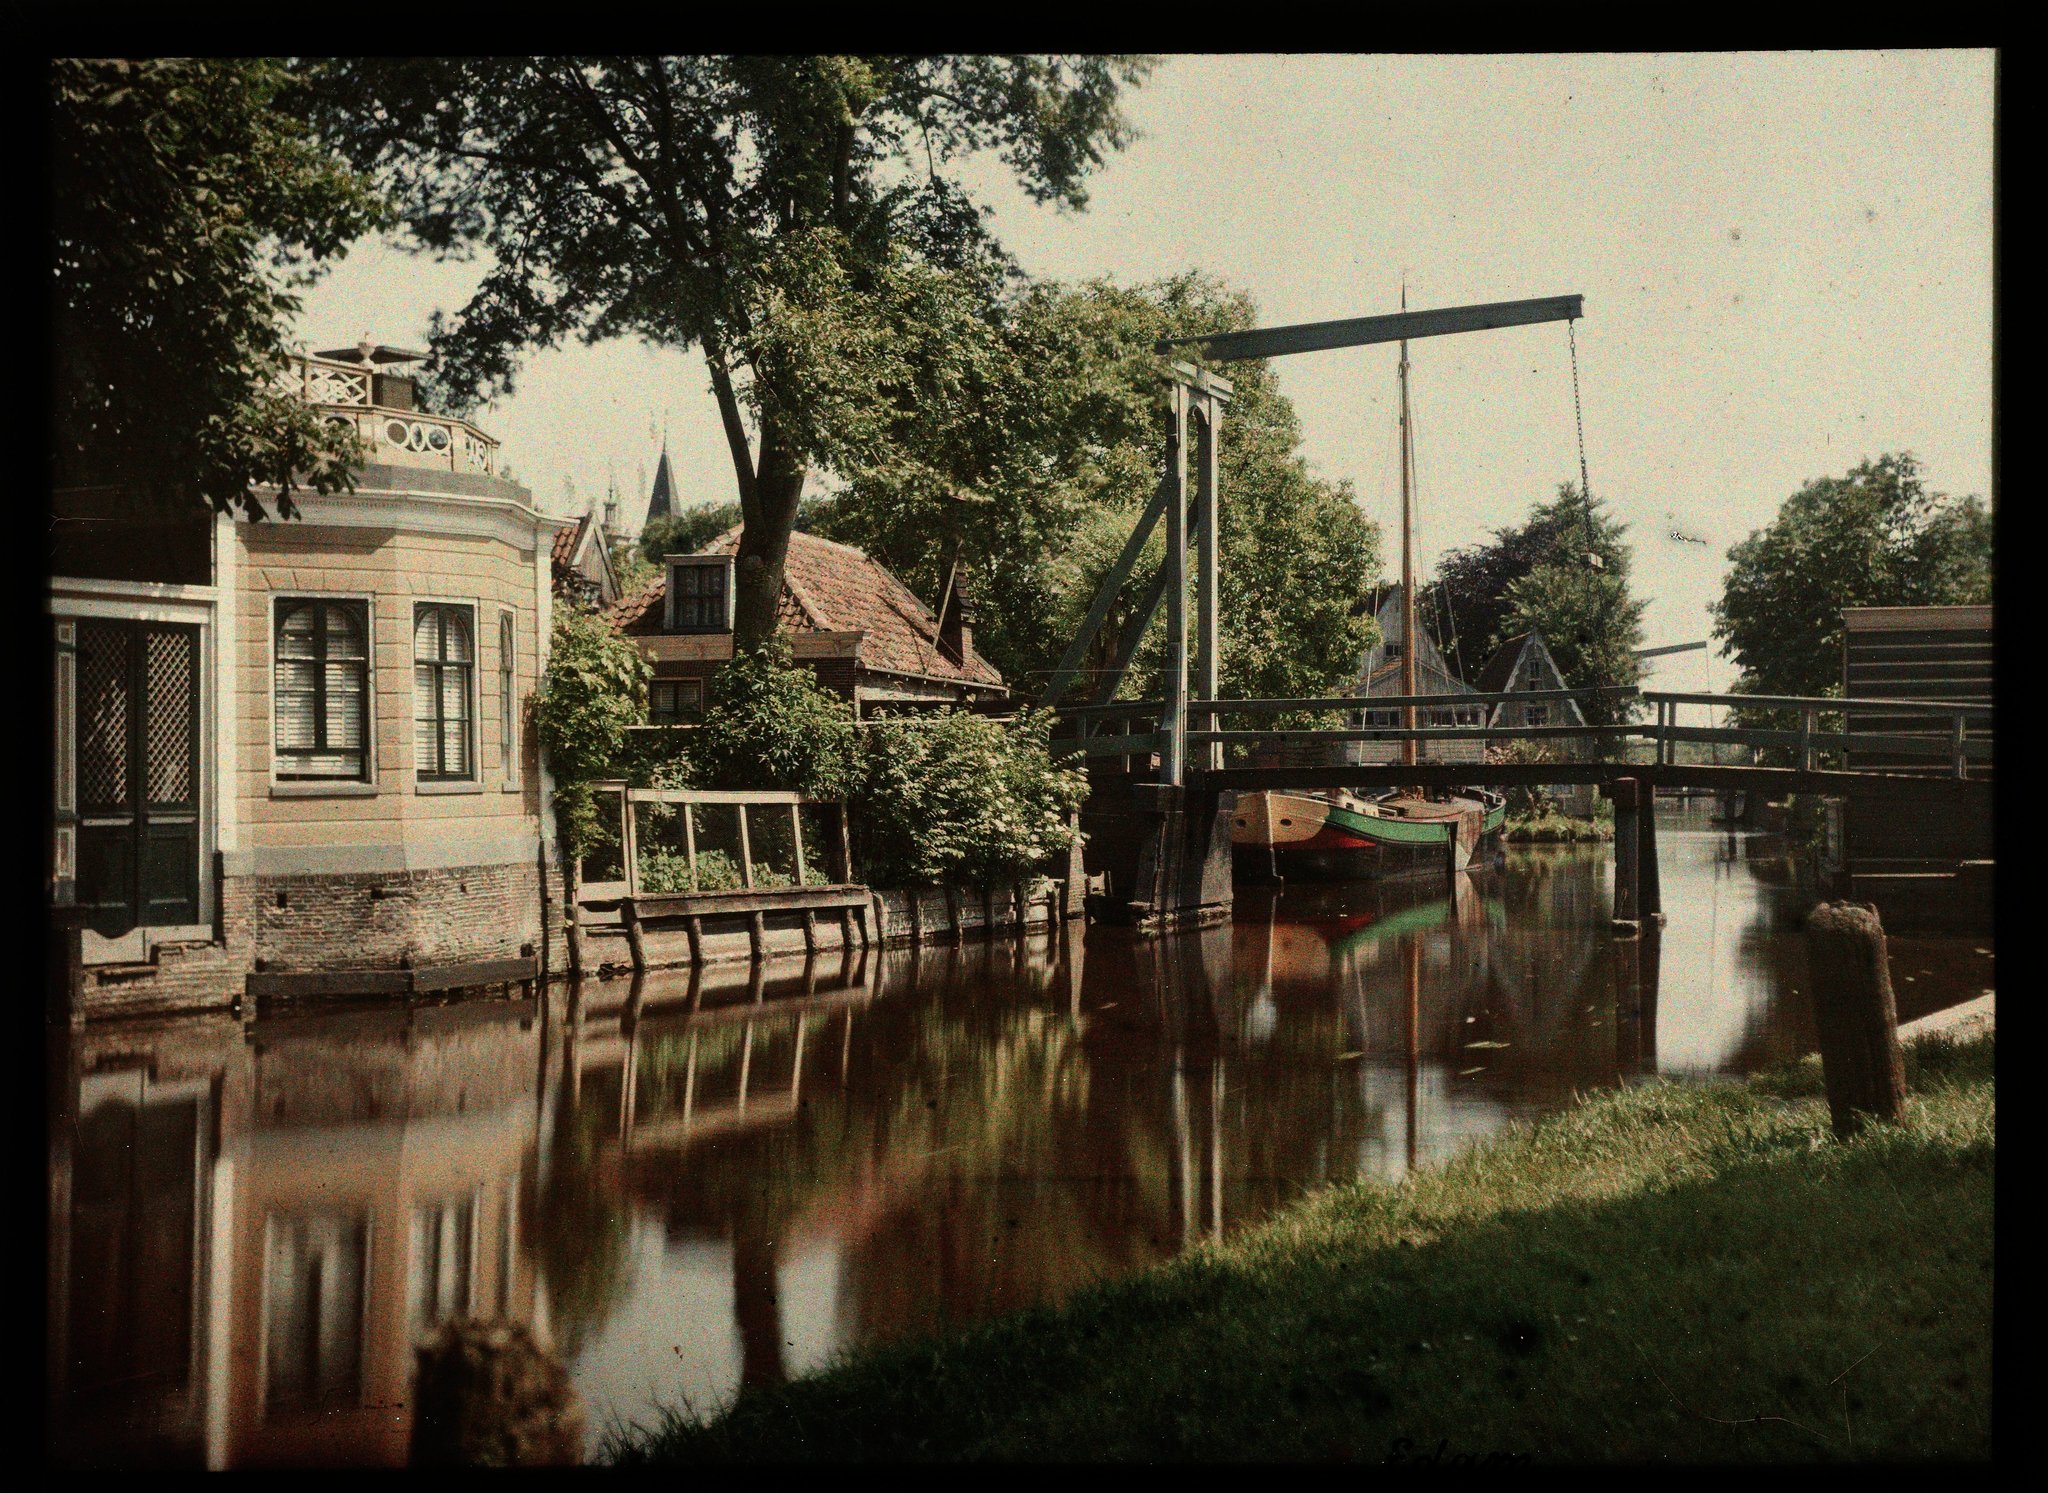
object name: glasdia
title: Gezicht op op de Lingerzijde te Edam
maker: Anonymous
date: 1907-1930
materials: glass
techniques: autochrome process, slide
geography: edam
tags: lingerzijde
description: Gezicht op een vaart met een houten ophaalbrug, een theekoepel (links), een schip en de huizen en aan de Lingerzijde te Edam.